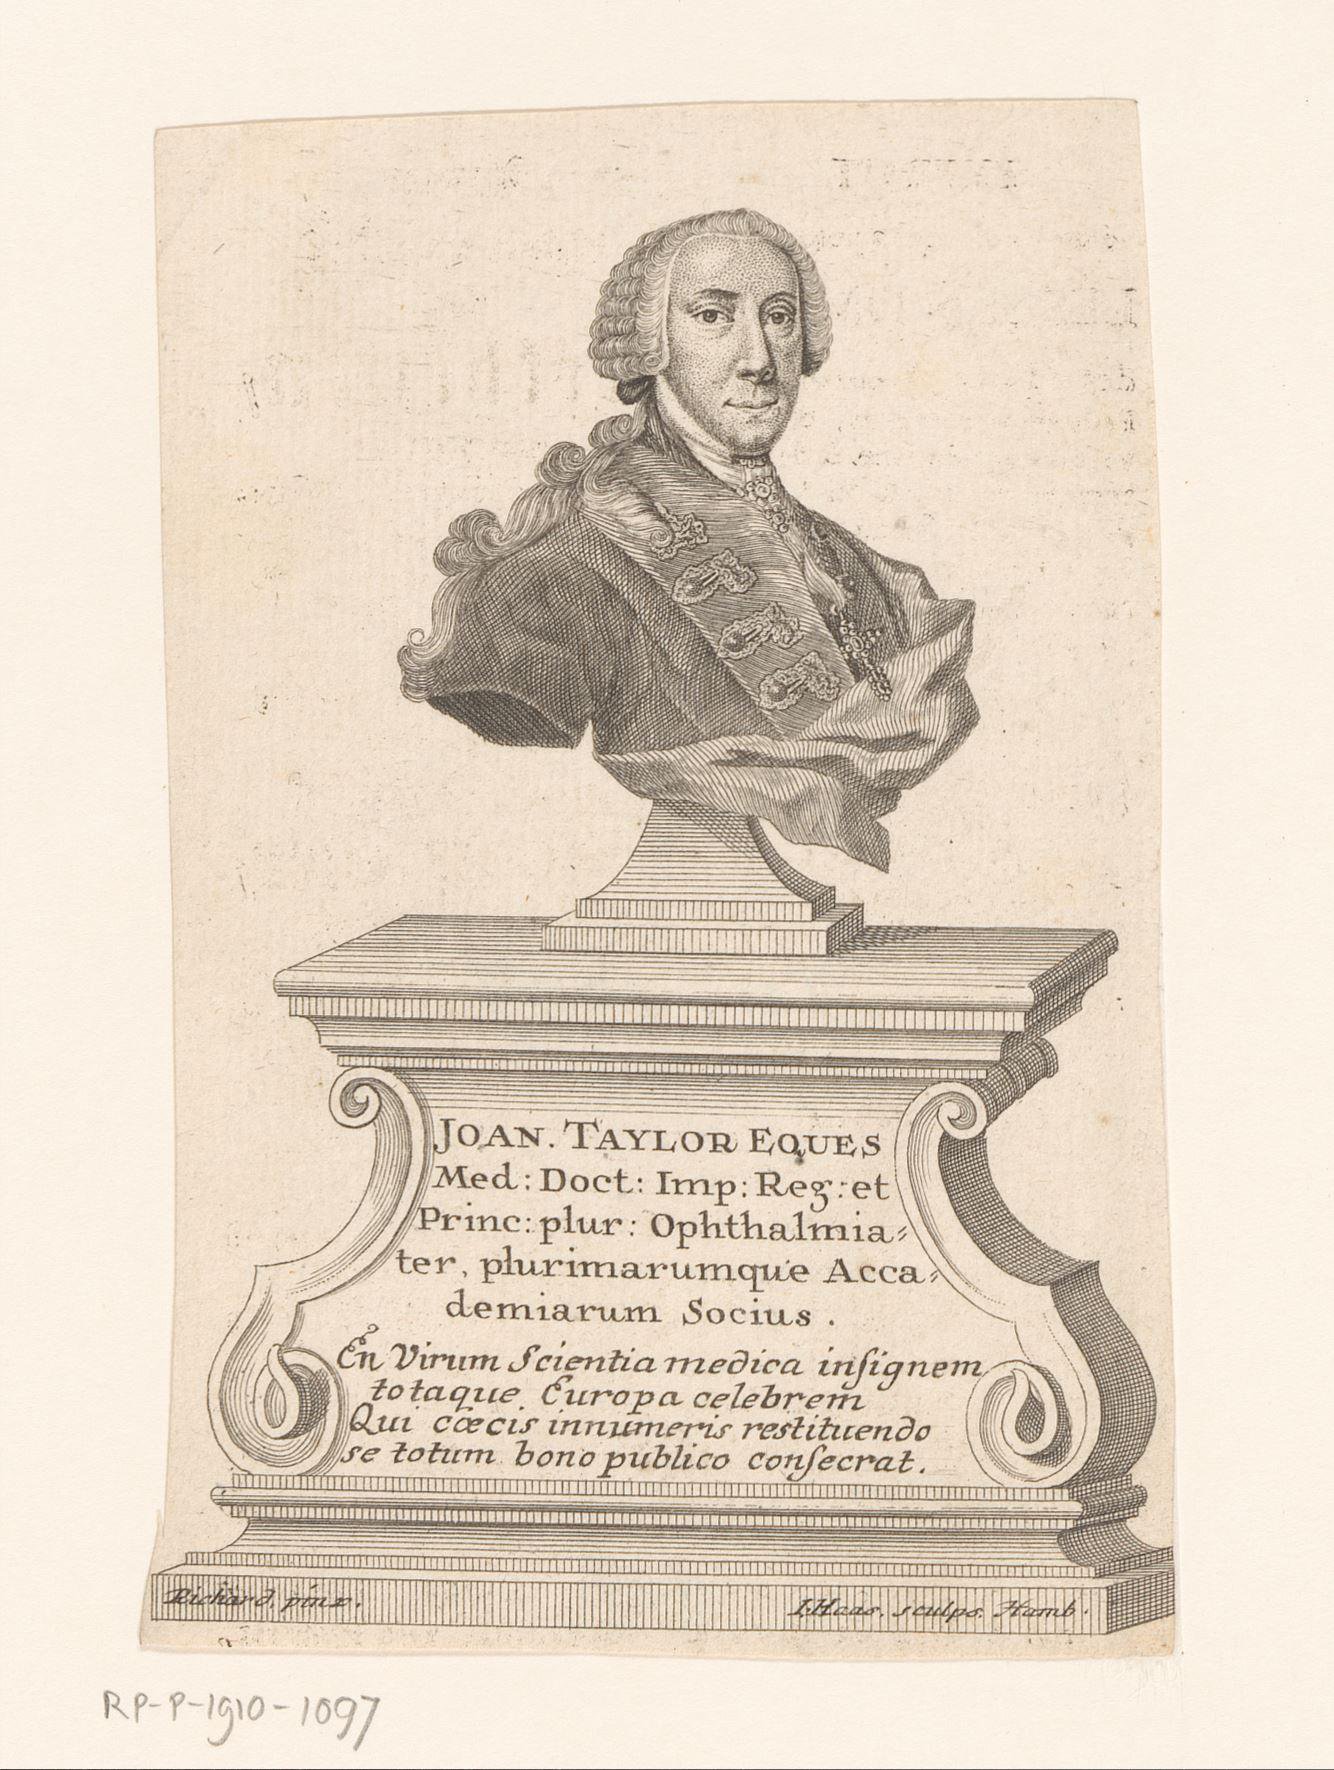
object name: print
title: Joan Taylor Eques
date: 1730-1775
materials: paper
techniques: engraving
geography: hamburg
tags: historical persons, physician, doctor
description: Portret van de Engelse arts John Taylor, borstbeeld op voetstuk, met Latijnse onderschriften.